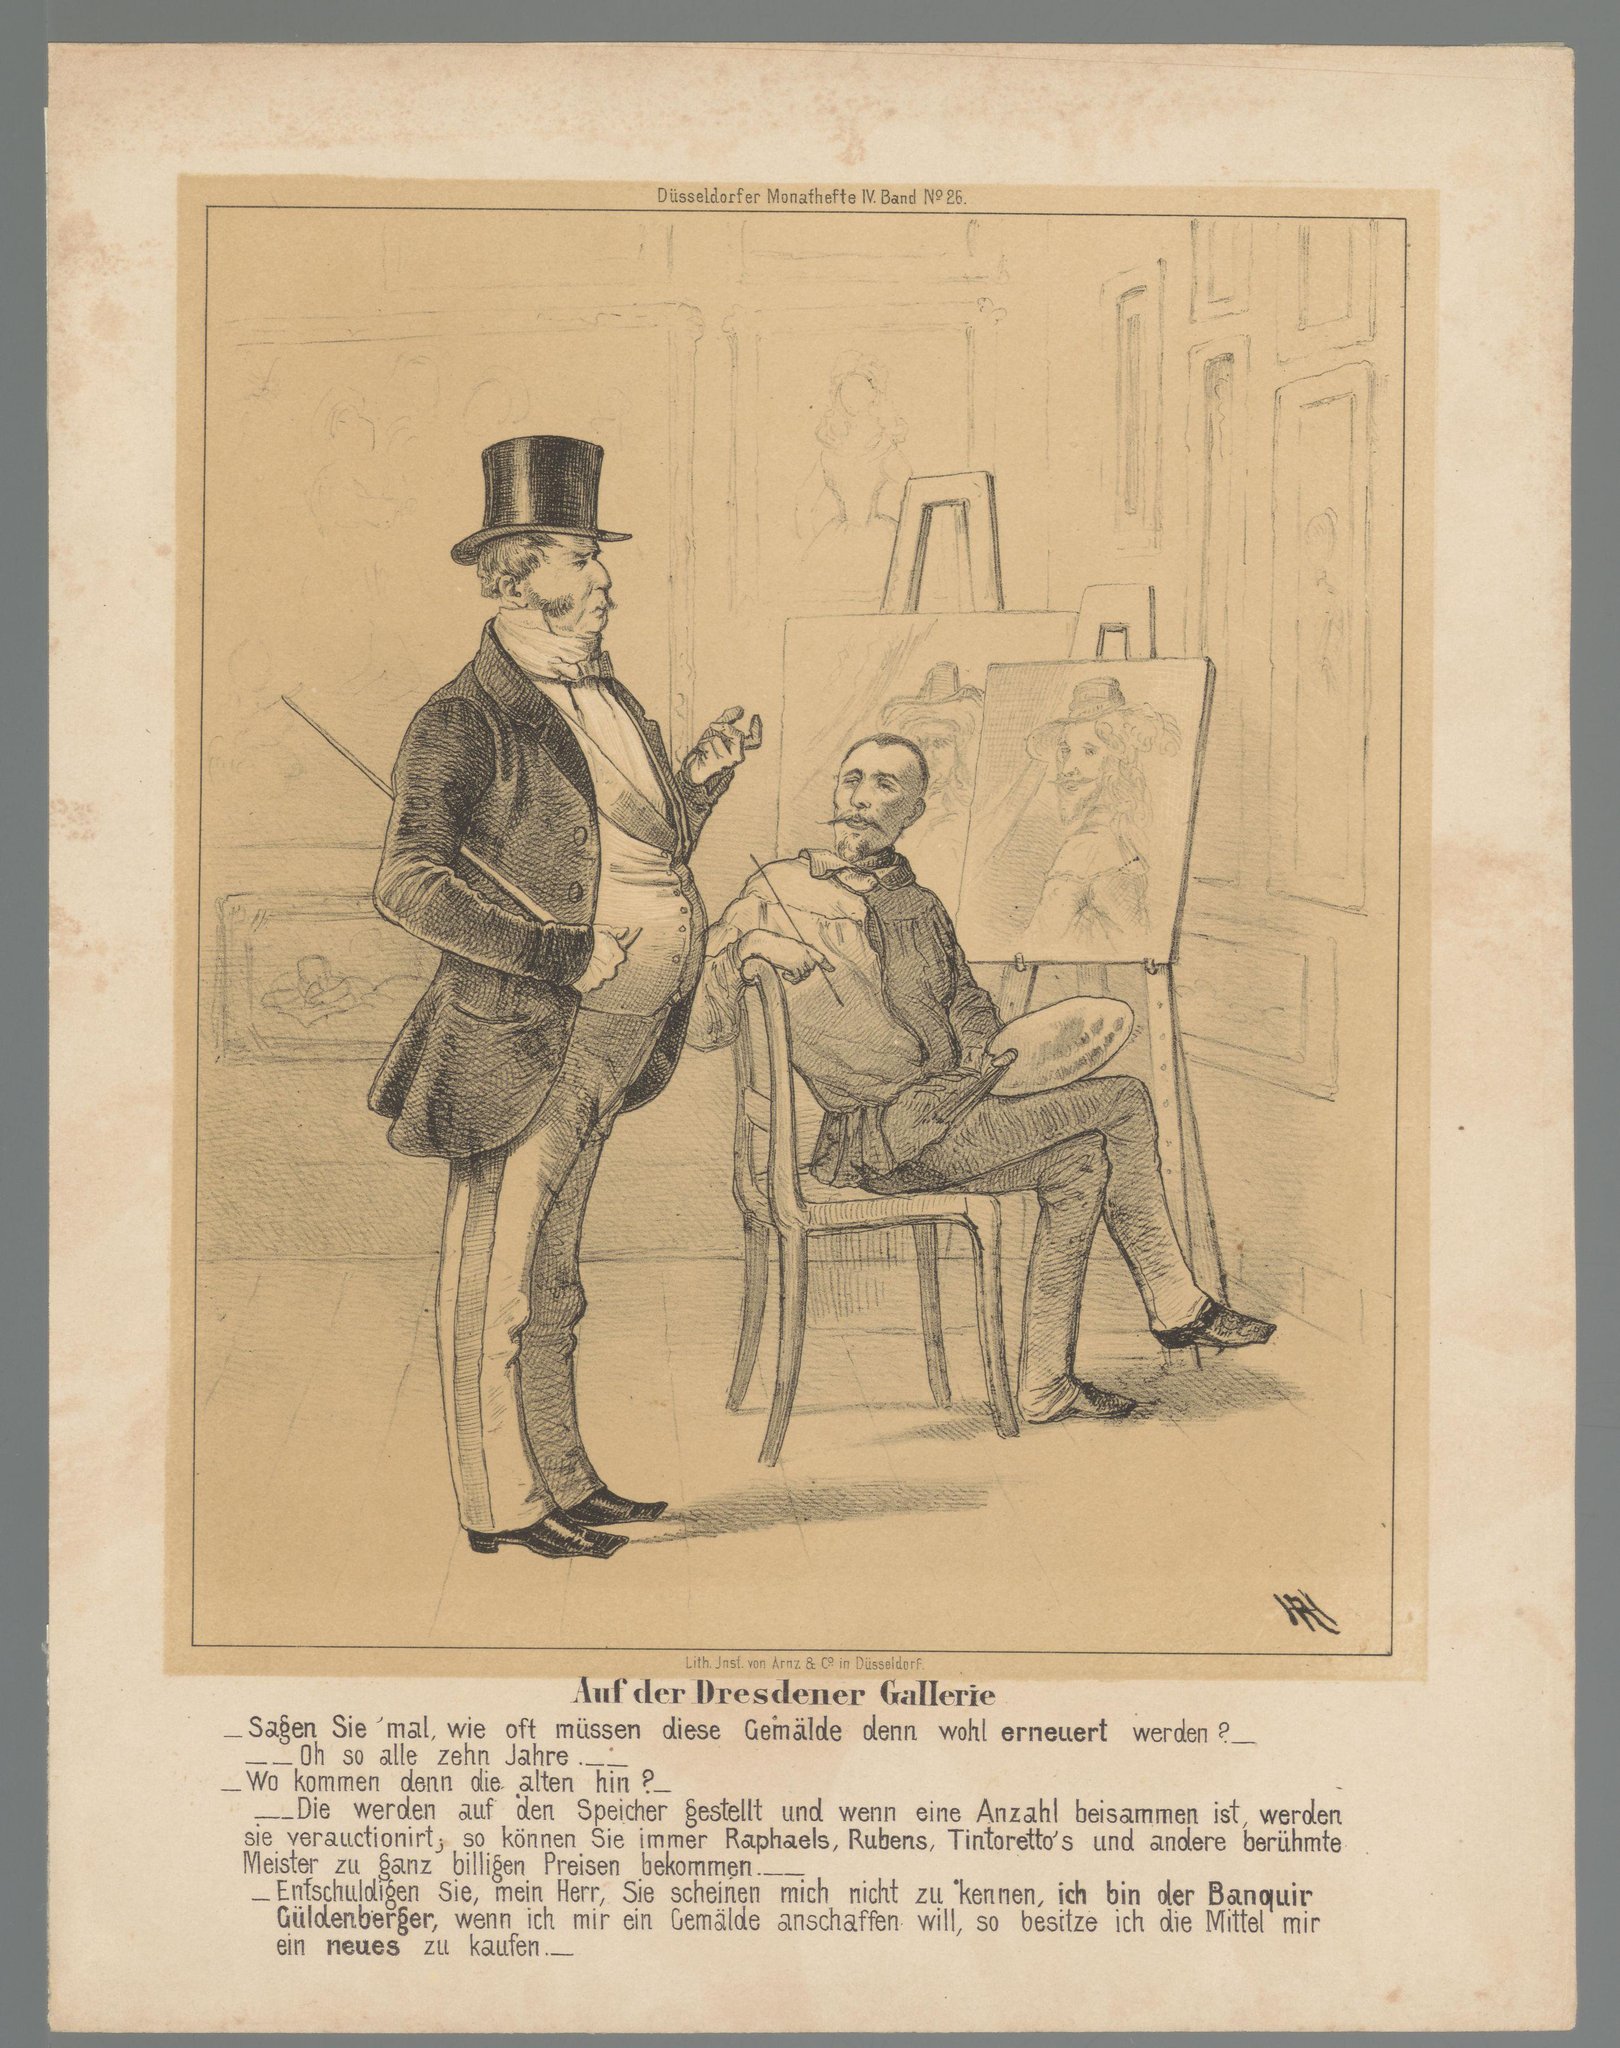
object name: print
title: Auf der Dresdener Gallerie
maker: monogrammist hr (duitsland)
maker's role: print maker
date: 1851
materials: paper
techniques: tone lithography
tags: standing figure, painter at work, in his studio, easel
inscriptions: collector's mark: Lugt 2228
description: Prent uit: Düsseldorfer Monathefte 4 (1851), afb. 26.